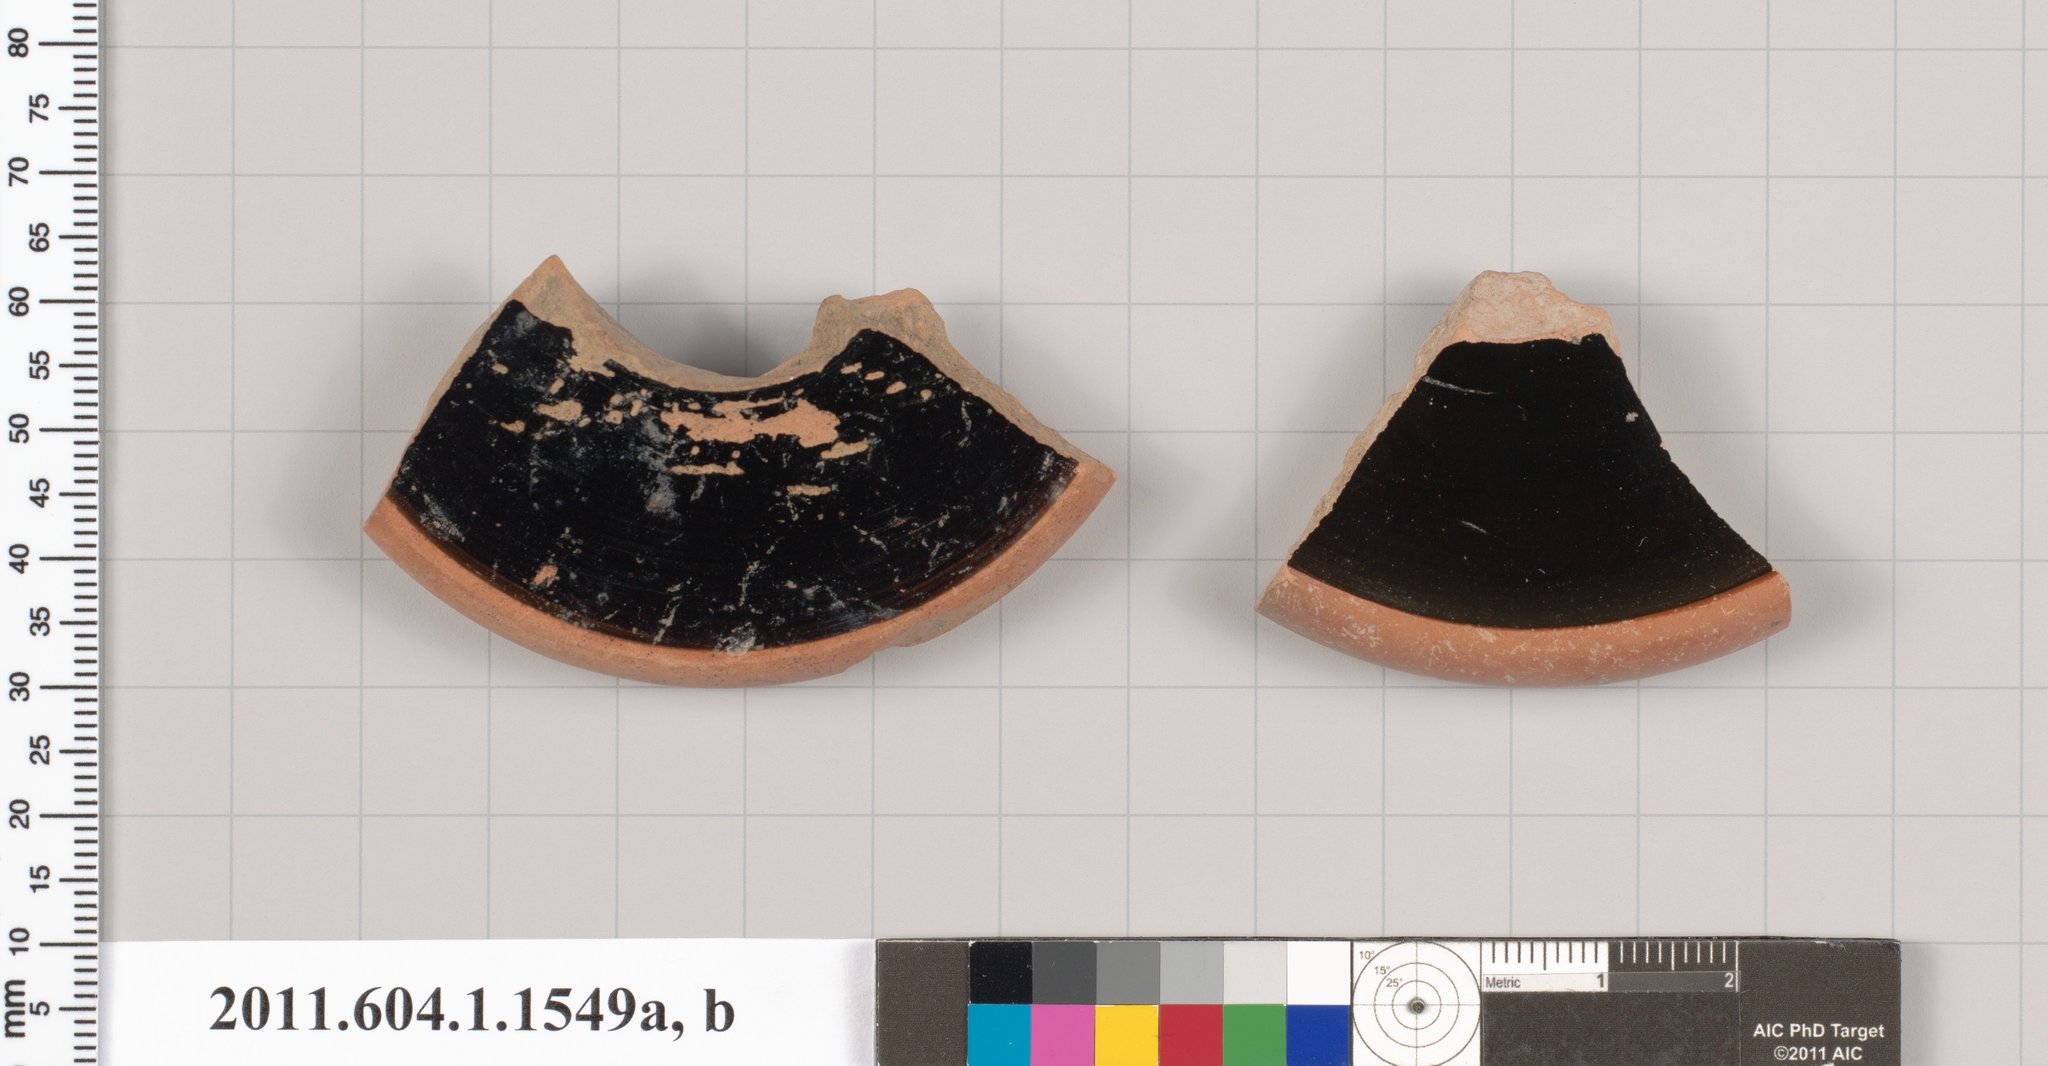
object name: kylix fragment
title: Terracotta fragments of kylikes (drinking cups)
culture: greek, attic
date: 500-401 BCE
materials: terracotta